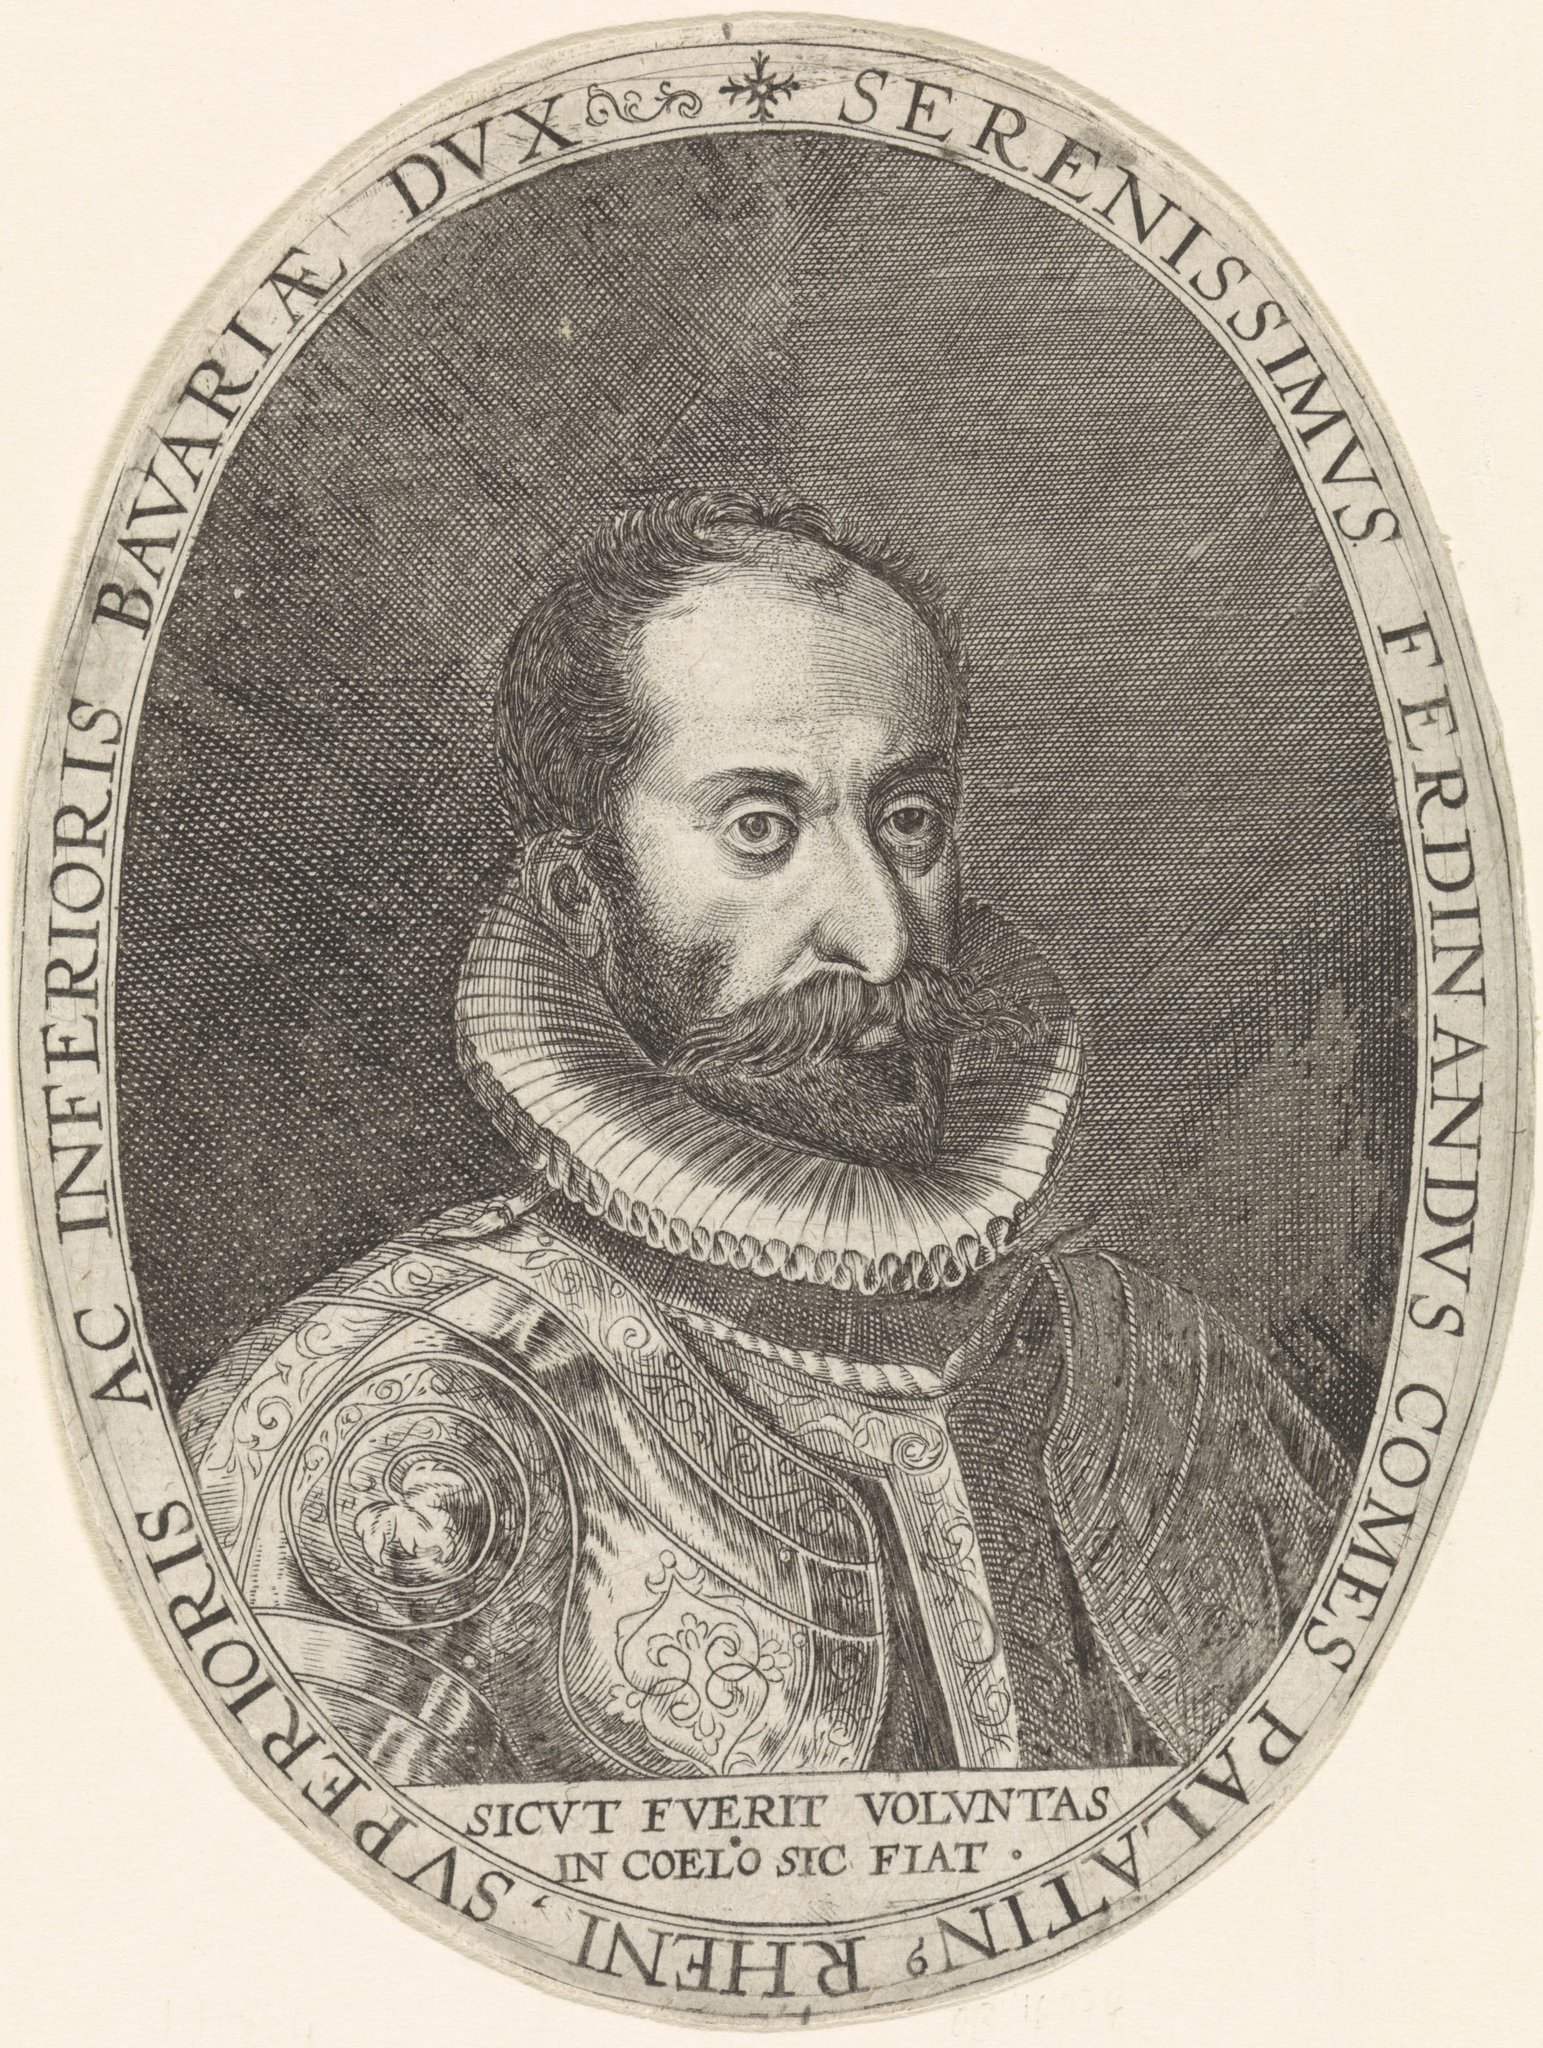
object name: print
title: Portret van Ferdinand van Beieren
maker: crispijn van de passe (i)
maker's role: draughtsman, print maker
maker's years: 1564-1637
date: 1574-1637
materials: paper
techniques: engraving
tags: ferdinand van beieren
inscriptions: collector's mark: Lugt 2228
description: Portret van de bisschop Ferdinand van Beieren, eronder zijn devies in het Latijn.